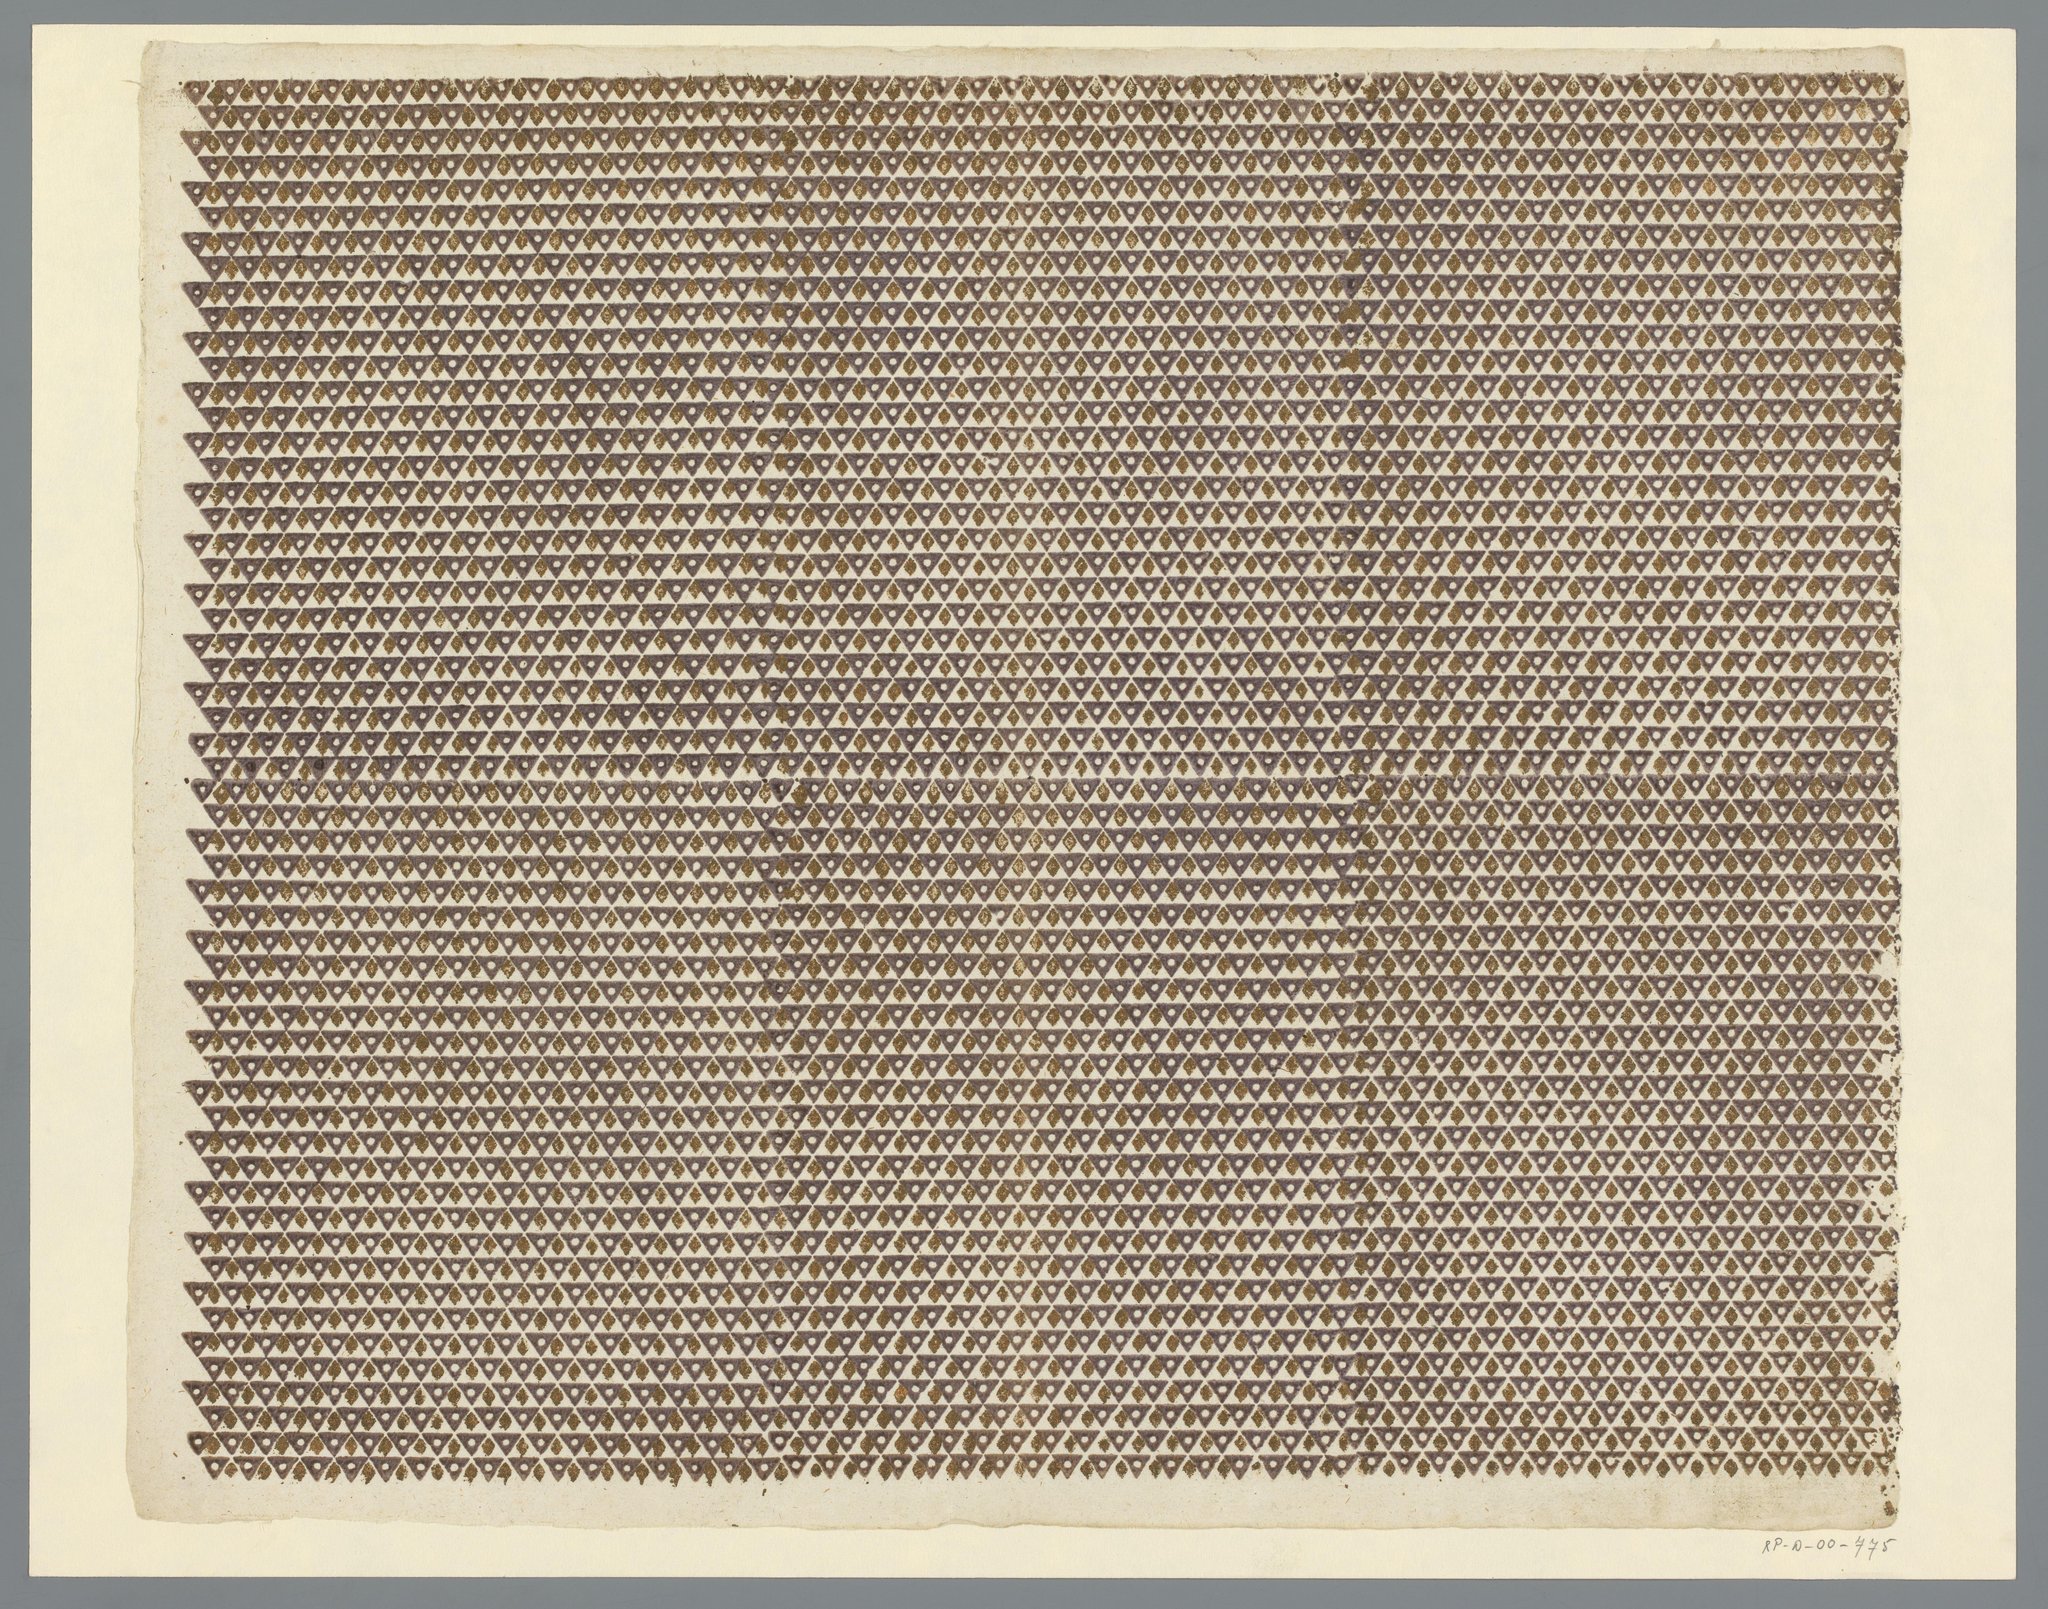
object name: printed paper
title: Blad met regelmatigpatroon van driehoeken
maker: Anonymous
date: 1750-1950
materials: paint, paper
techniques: printing block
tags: ornament derived from plant forms